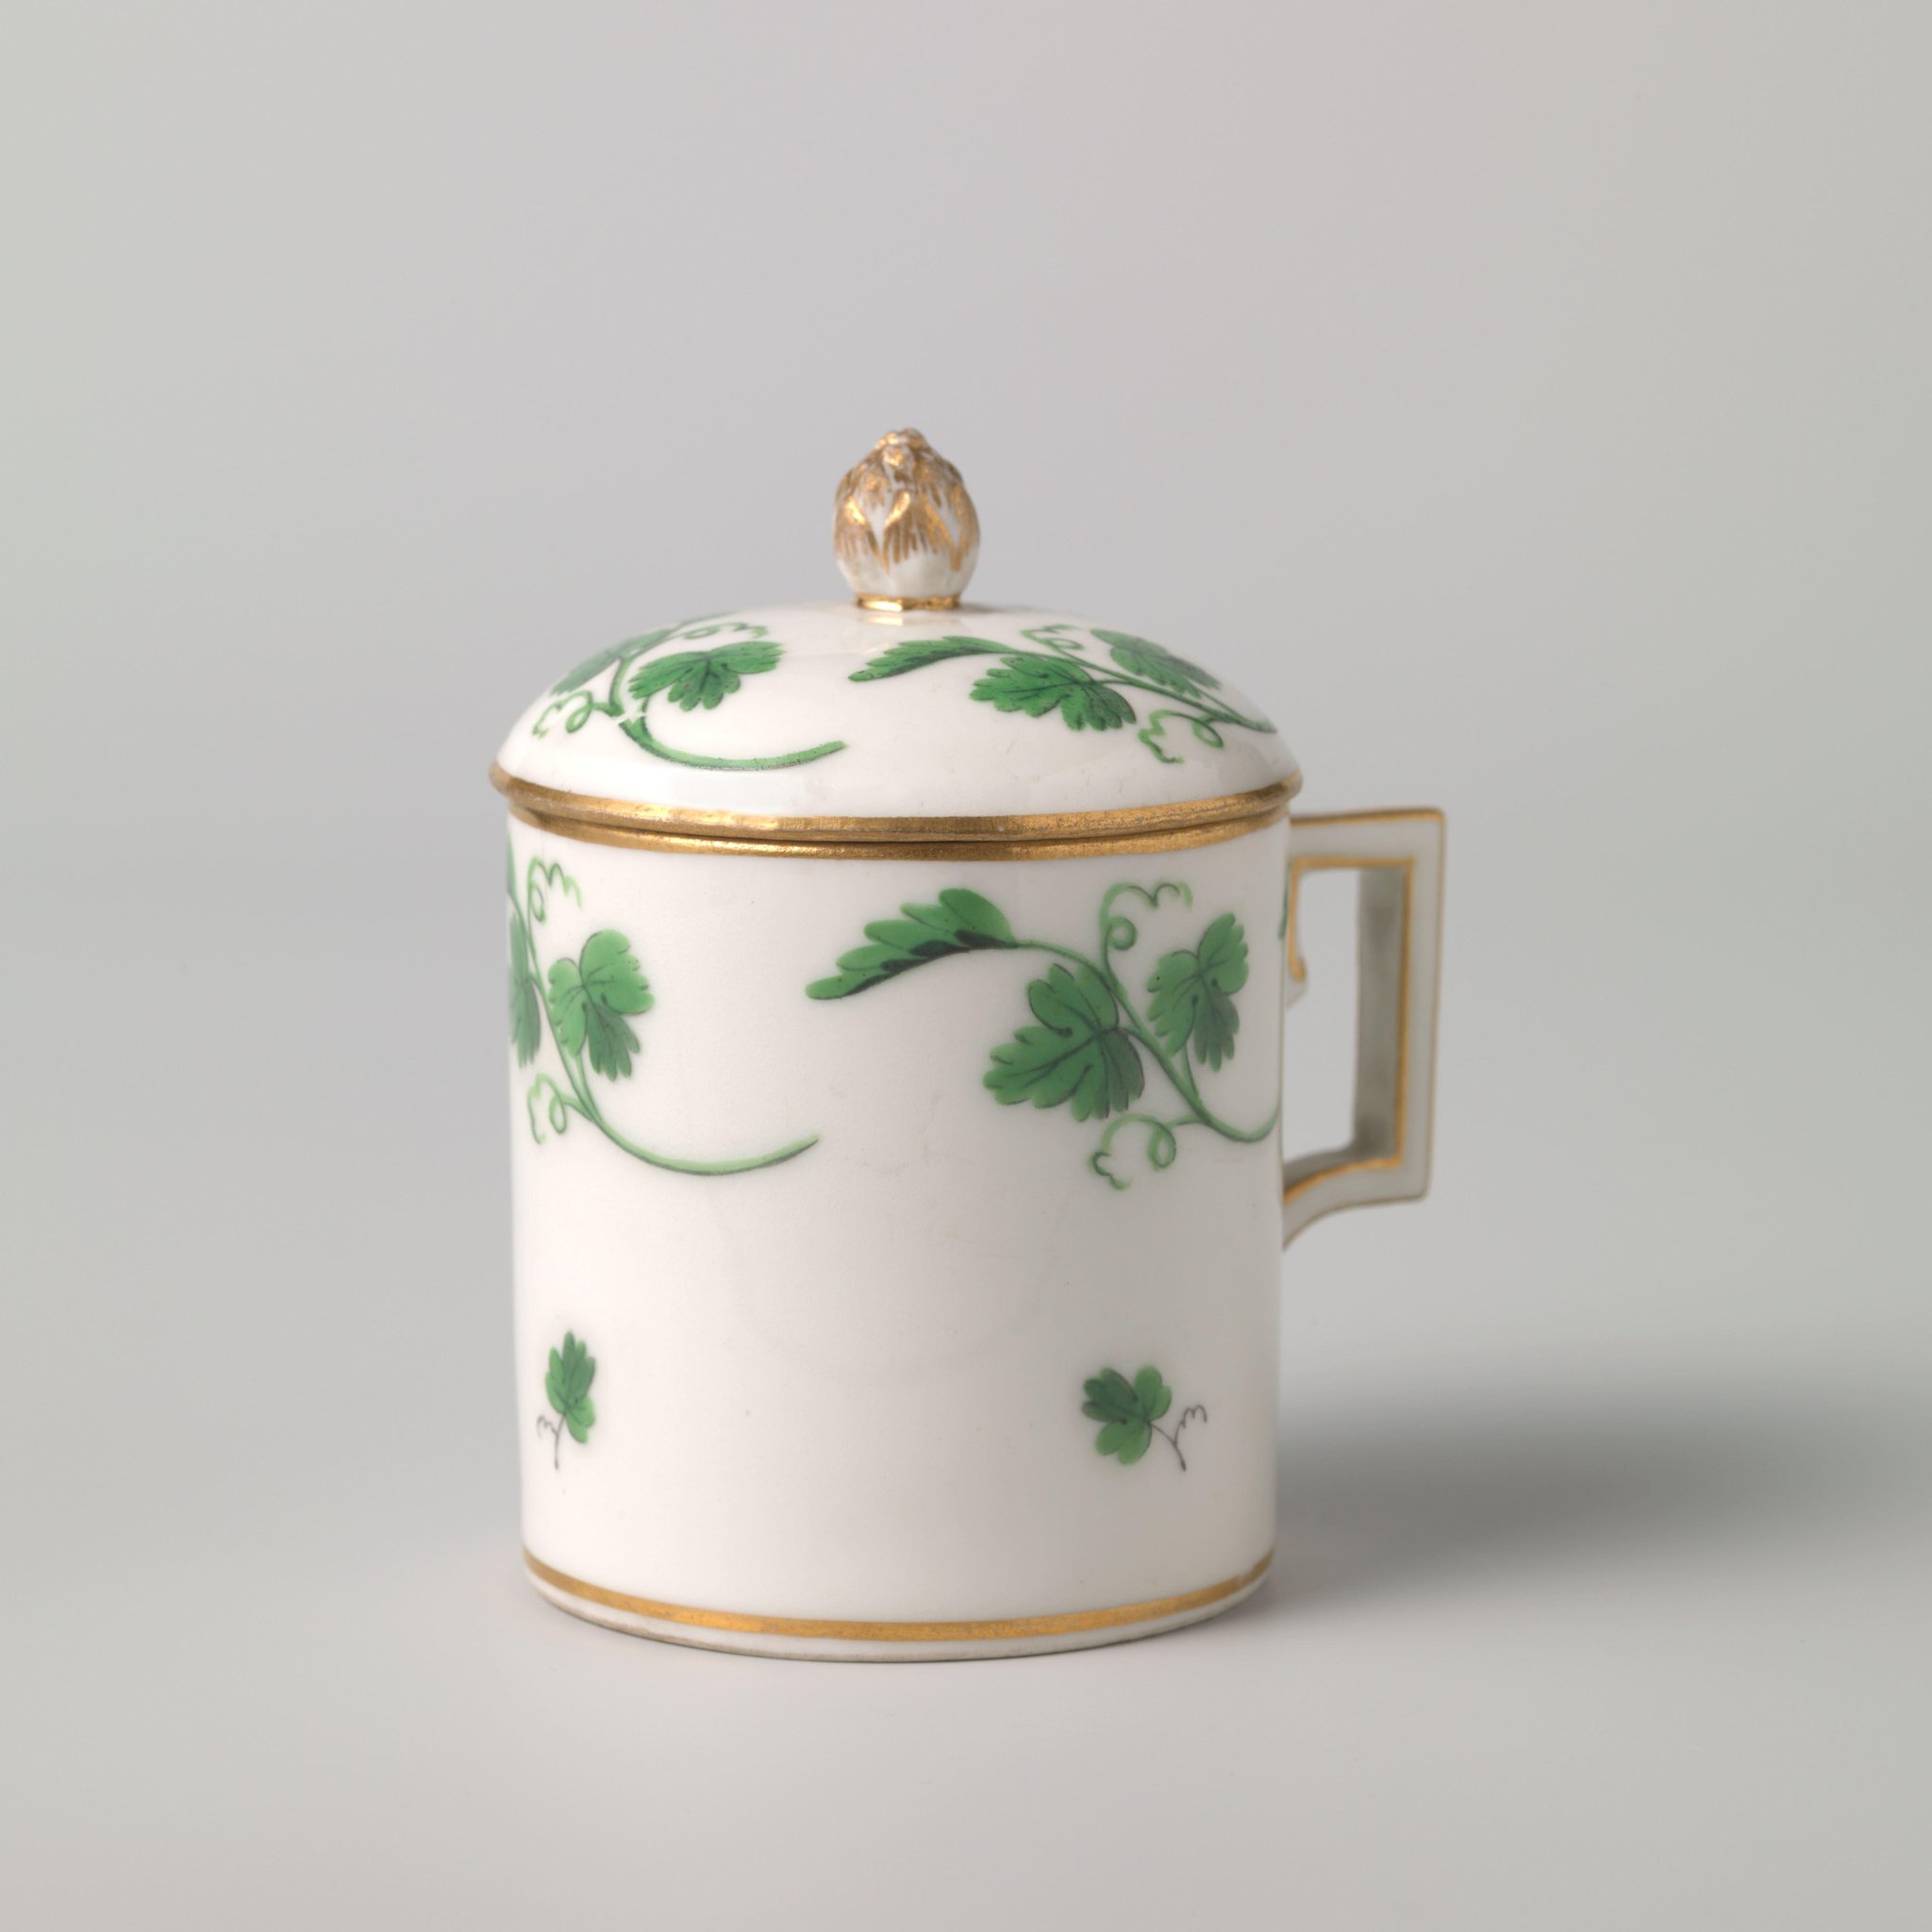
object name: lid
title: Cover with grapevines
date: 1800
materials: glaze, gold, paint, porcelain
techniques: firing, forming, gilding, turning, vitrification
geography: vienna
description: Deksel van een kop van porselein, beschilderd op het glazuur in groen, zwart en goud. Versierd met wijnranken en dekselknop in de vorm van een bloemknop.